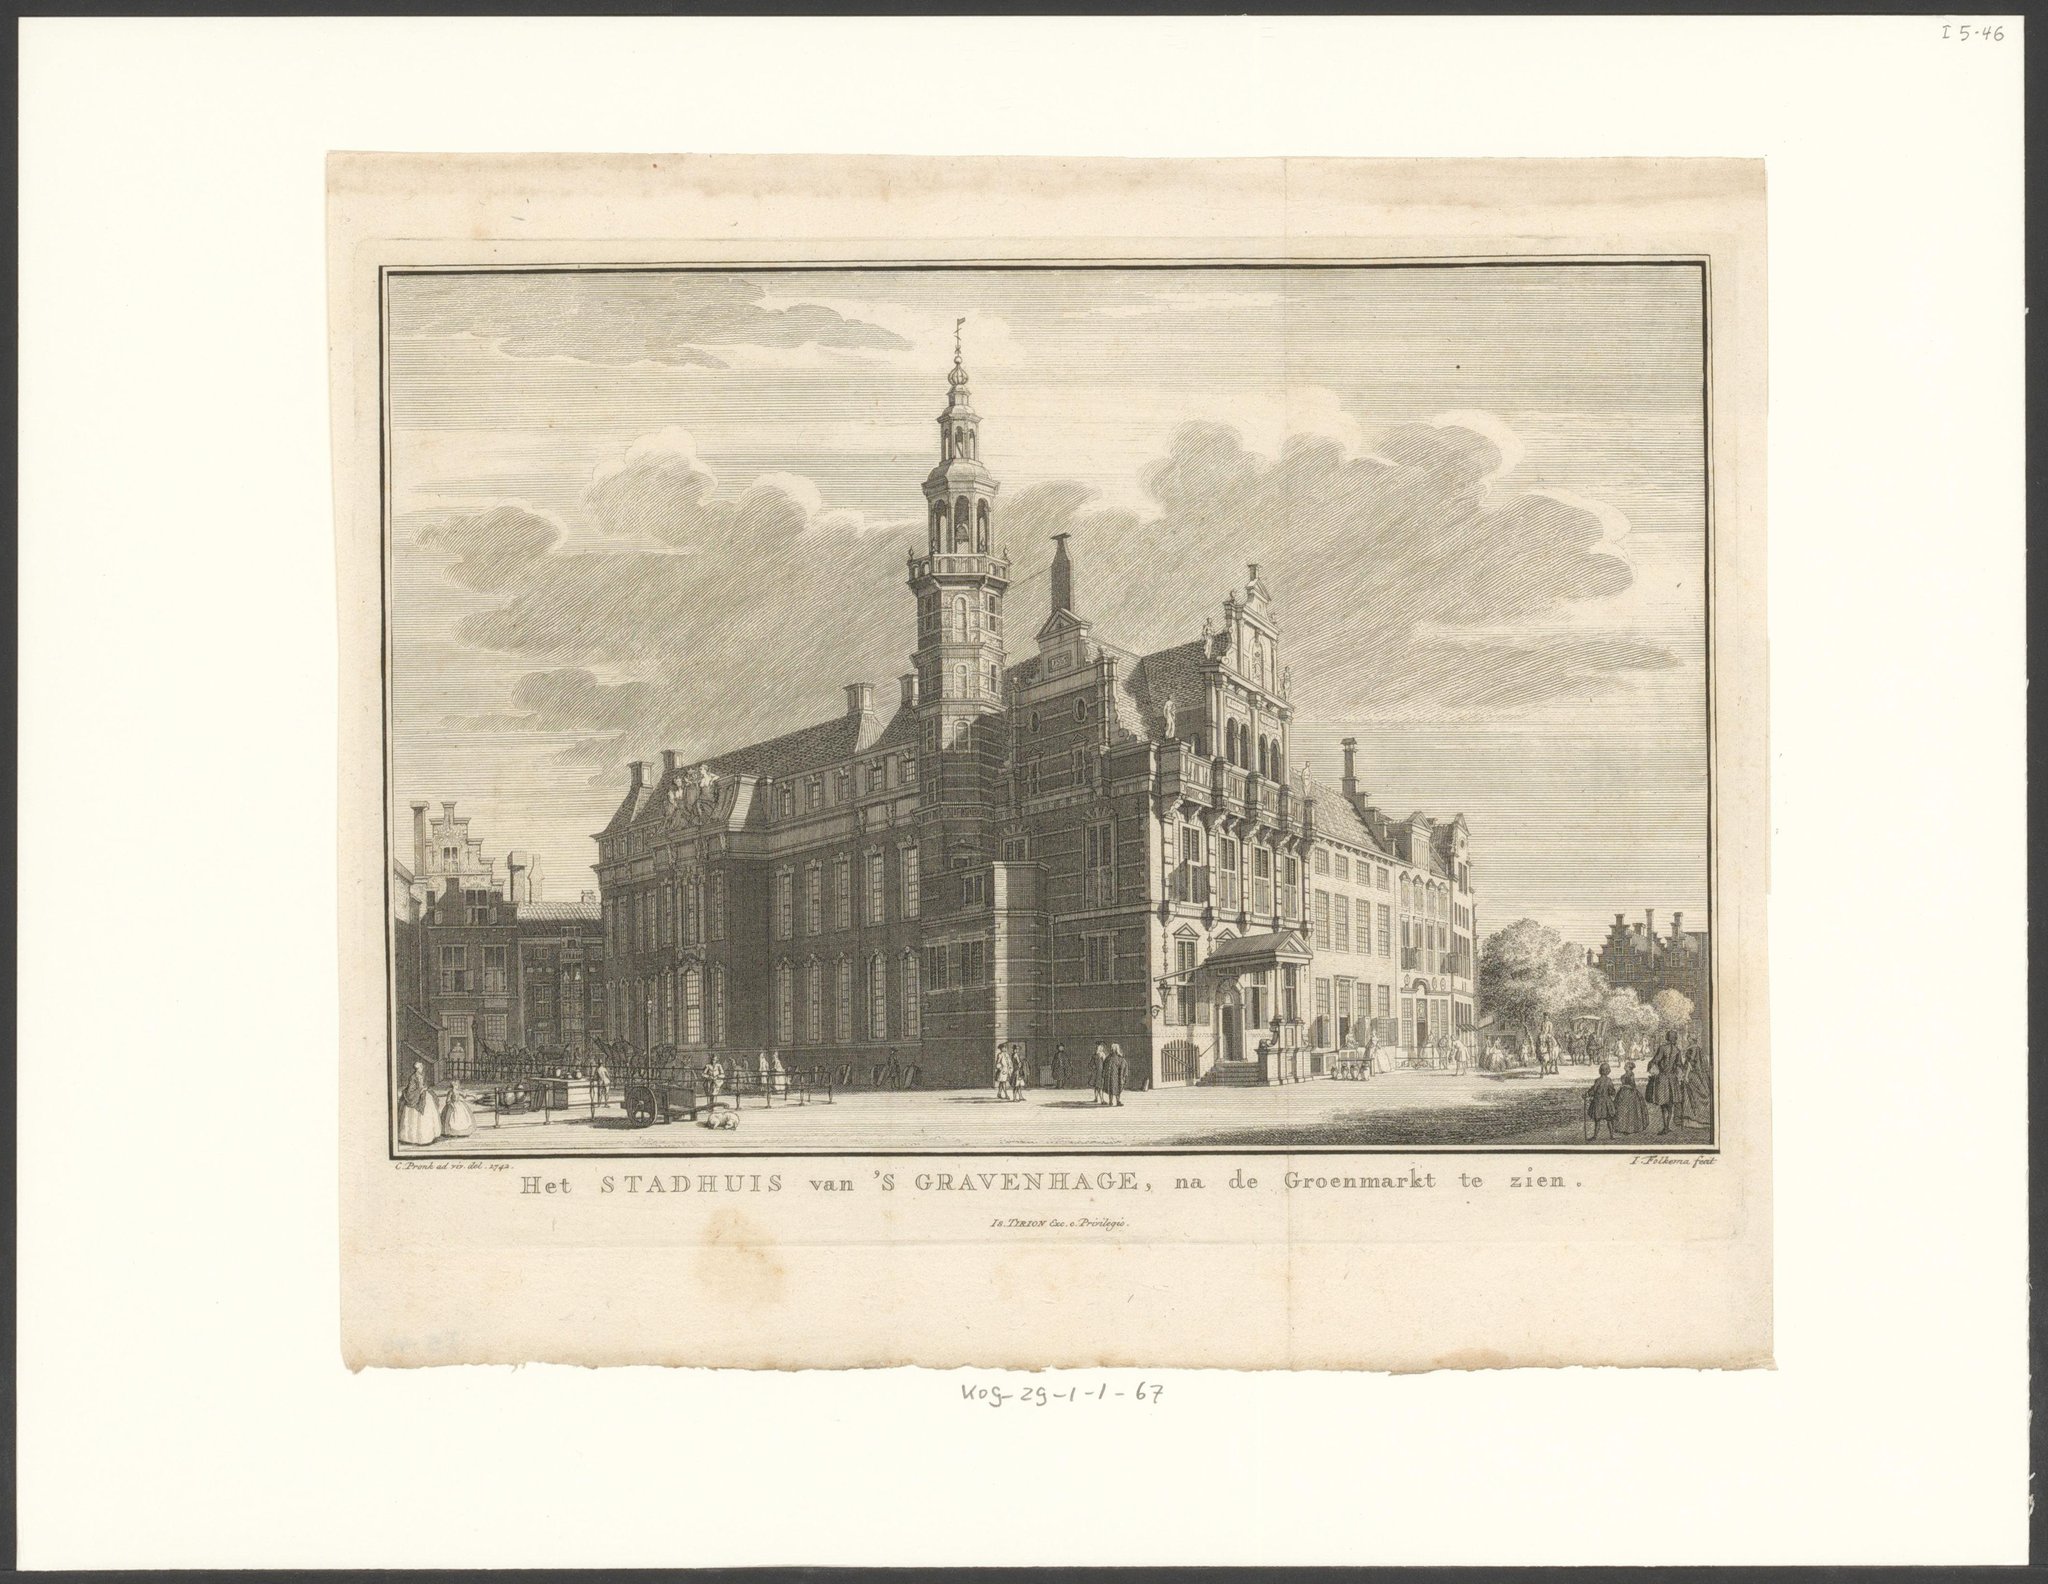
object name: print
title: Het Stadhuis van 's Gravenhage, na de Groenmarkt te zien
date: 1745-1746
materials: paper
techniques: engraving, etching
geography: amsterdam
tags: townhall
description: Prent ook gebruikt in: Tegenwoordige staat der Vereenigde Nederlanden, zesde deel. Behelzende het vervolg der beschryvinge van Holland. Met nieuwe kaarten en kunstige printverbeeldingen versierd / Hedendaagsche historie, of tegenwoordige staat van alle volkeren; XVIde deel (…). Amsterdam: Isaak Tirion, 1746, tussen p. 60 en 61.